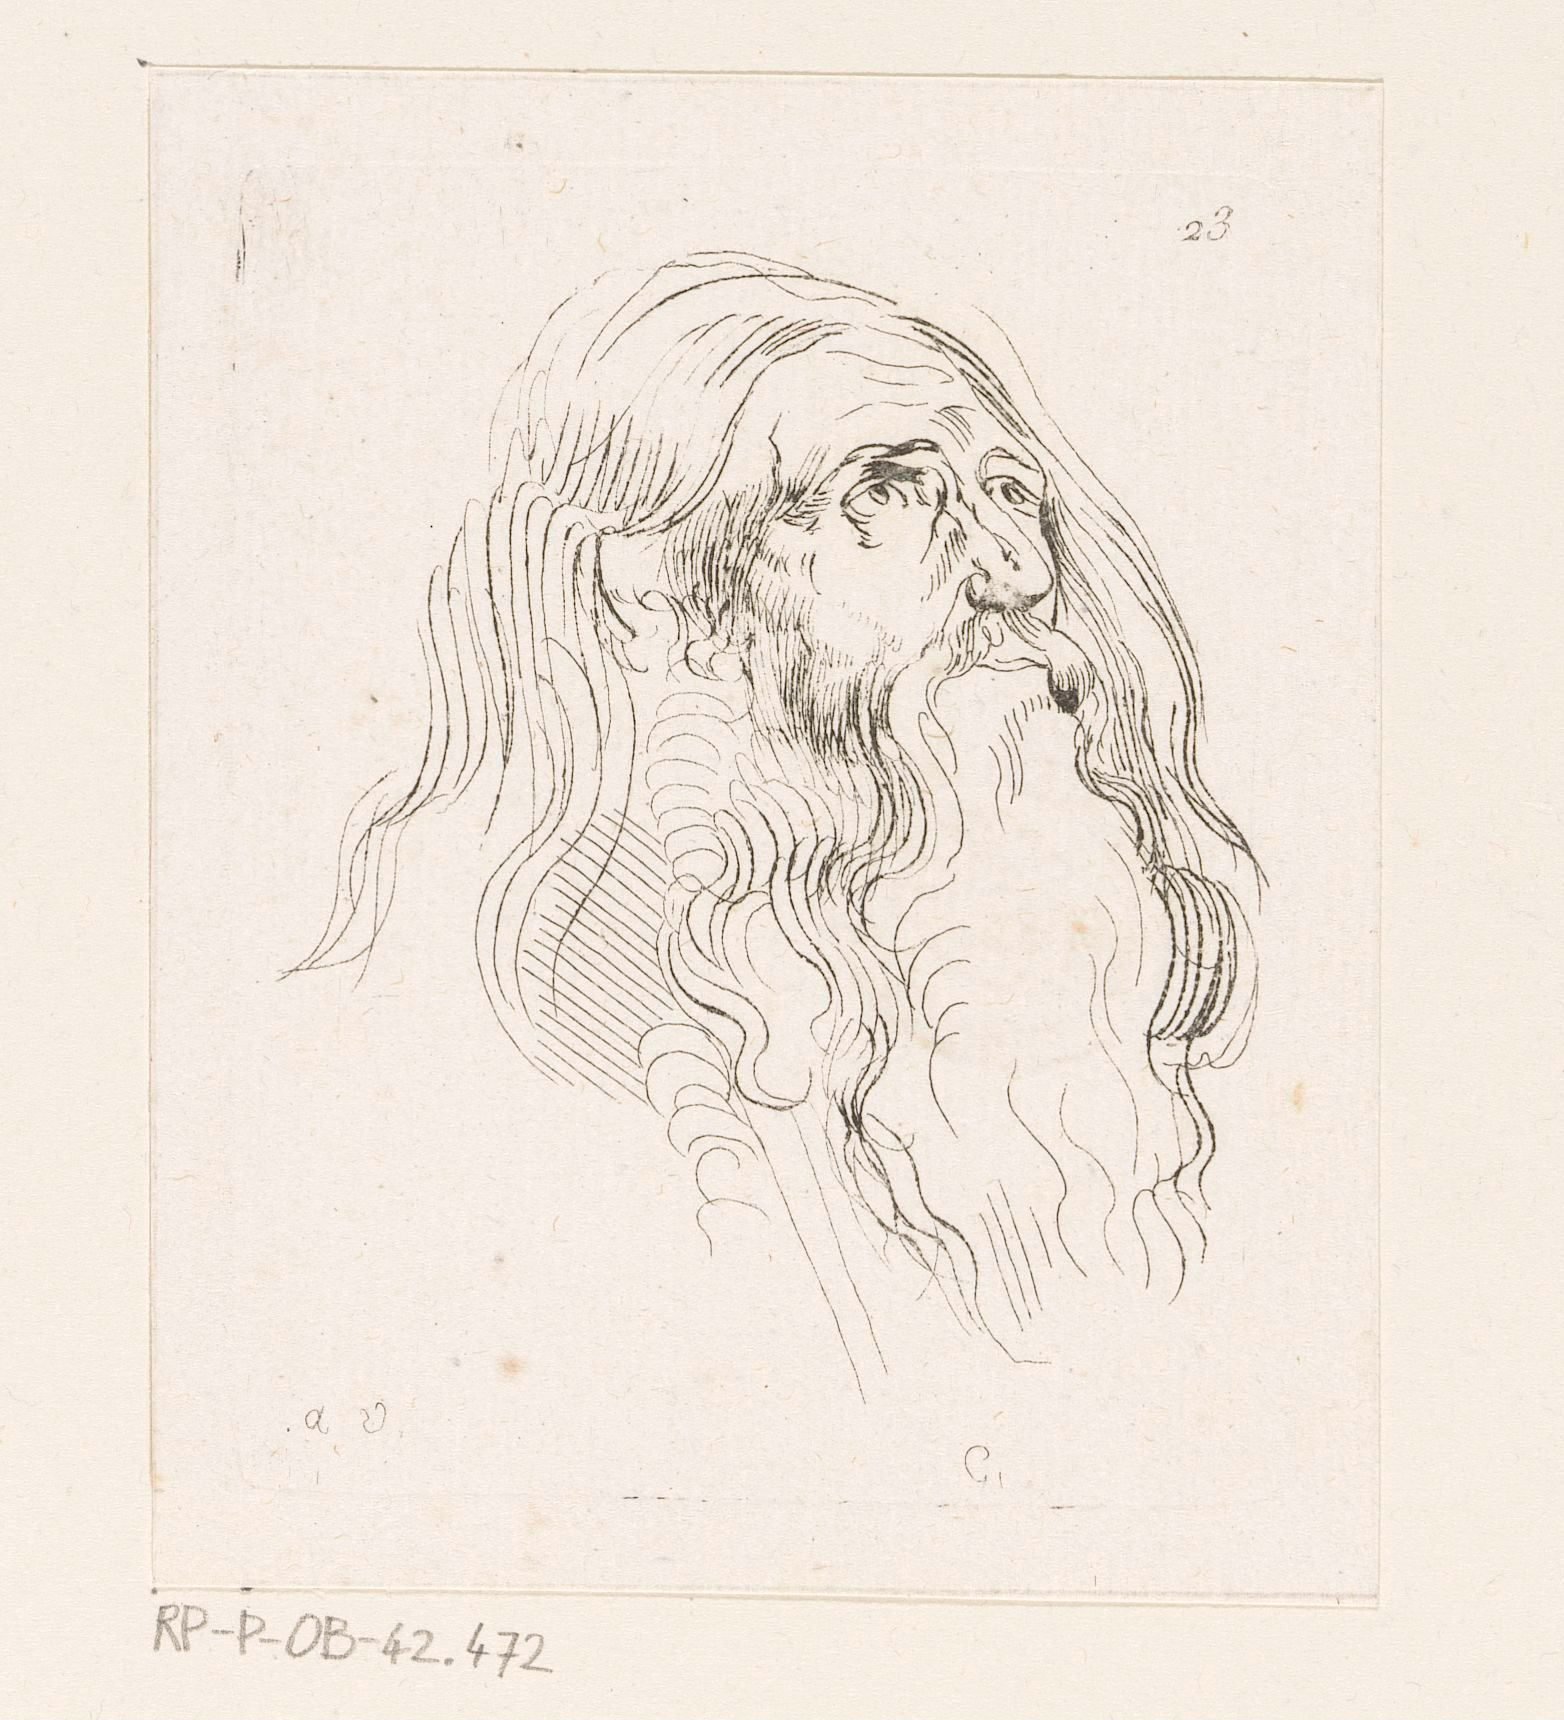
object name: print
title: Recueil de Testes d'Antoine Van Dyck (...)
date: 1735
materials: paper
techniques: etching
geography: france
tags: head (human), old man, beard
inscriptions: collector's mark: Lugt 240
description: Prent uit een serie van 31 prenten naar getekende hoofden door Van Dyck, plus een titelprent naar Bouchardon, getiteld: "Recueil de Testes d'Antoine Van Dyck tirées du Cabinet de M. Crozat et gravées par M. le C. de C.".